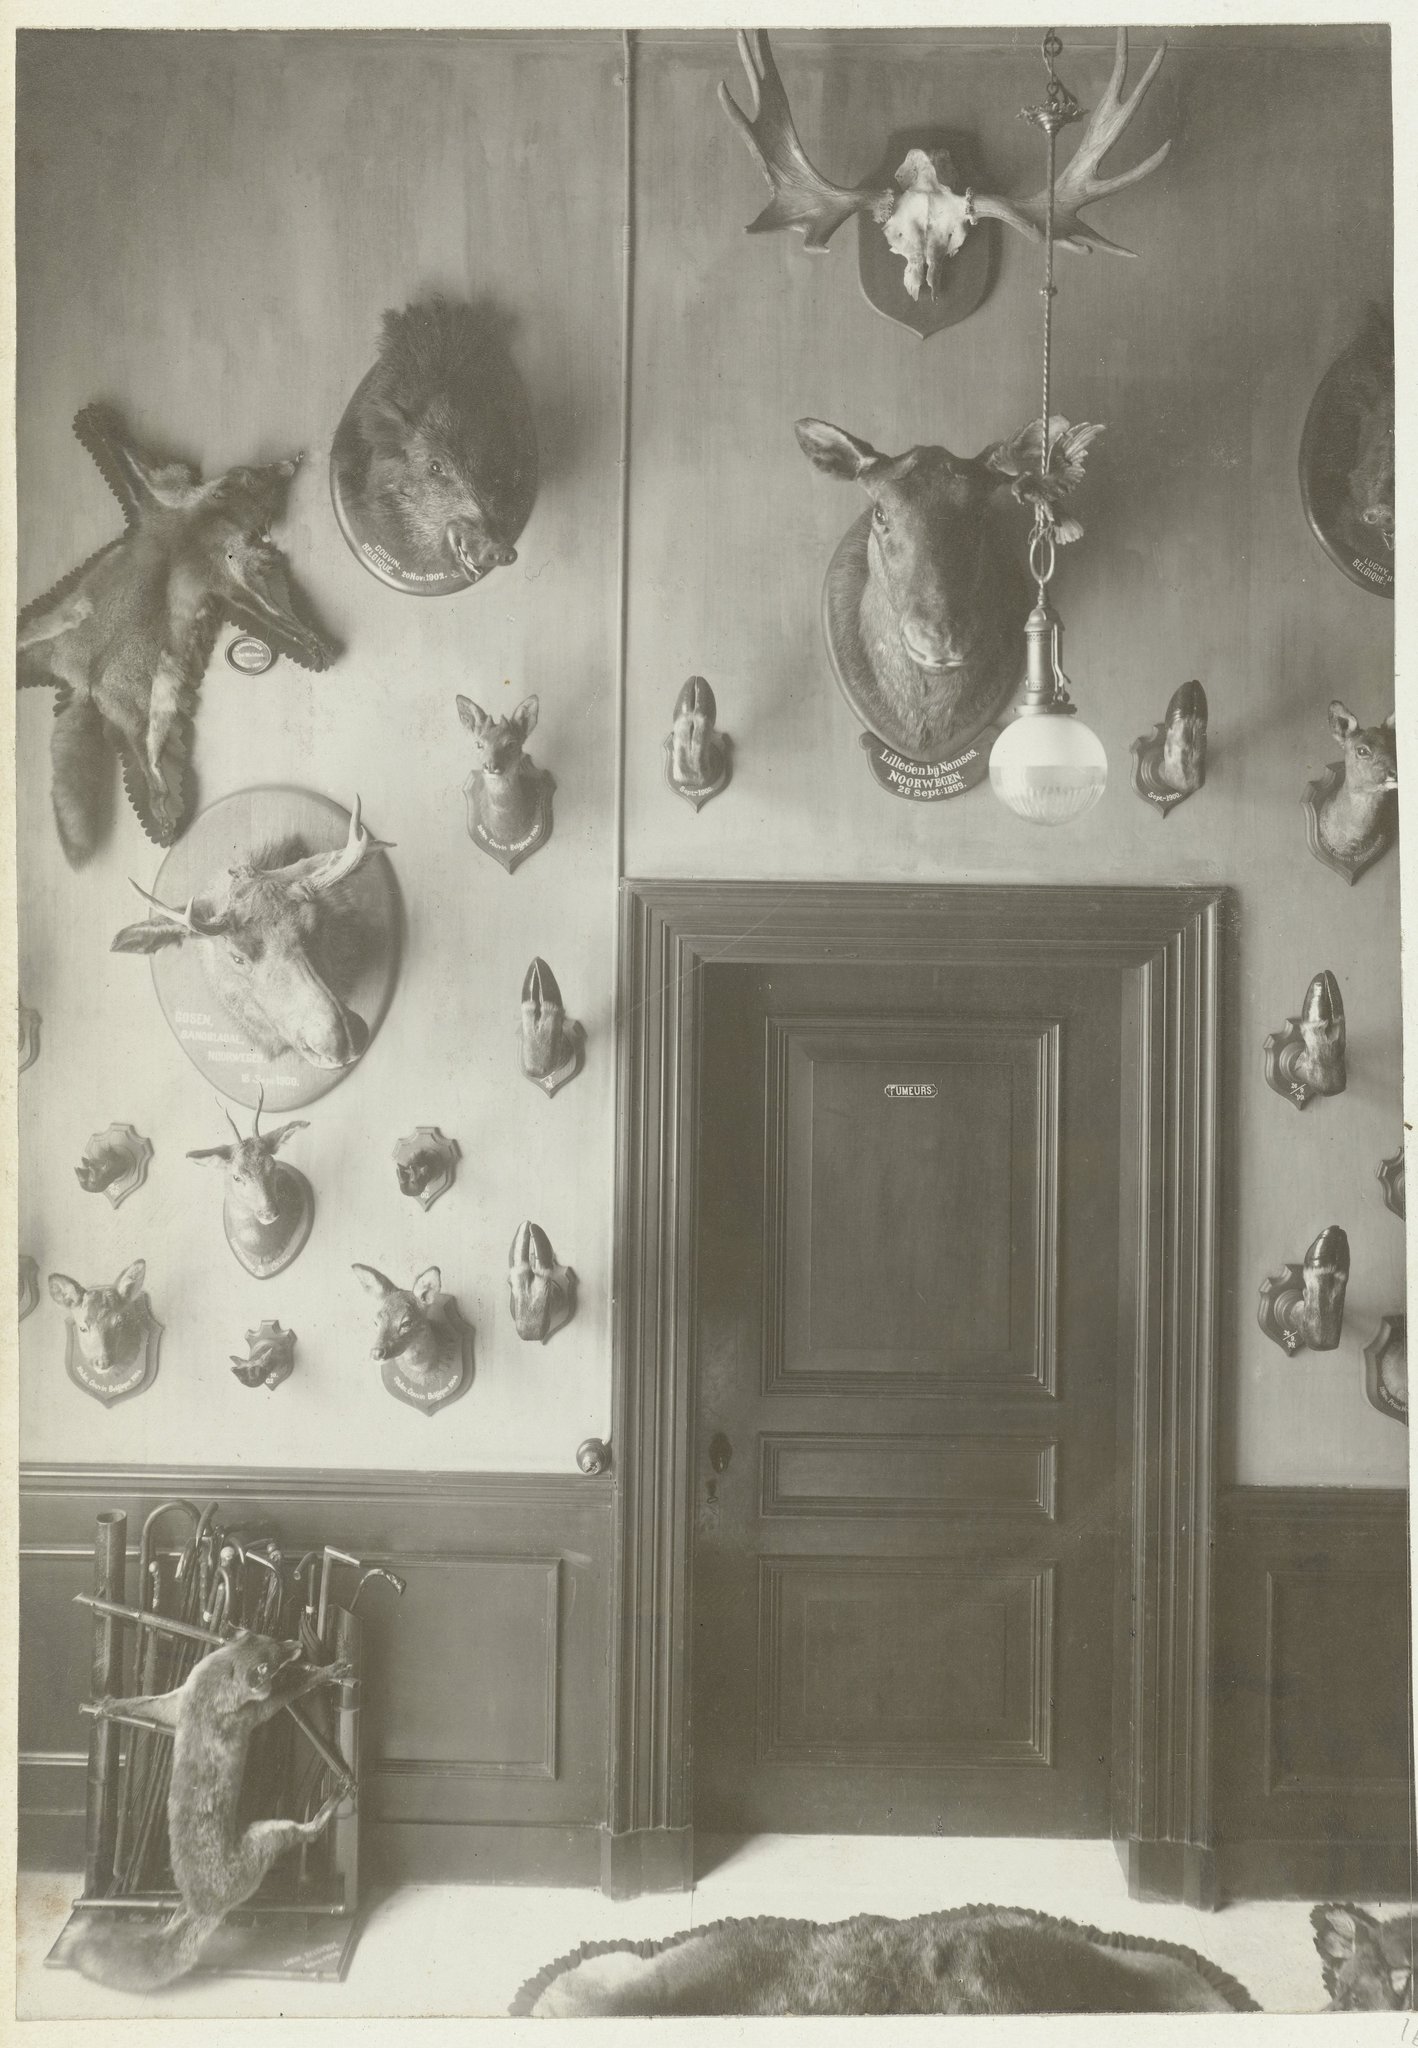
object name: photograph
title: Interieur van landhuis De Wildbaan met jachttrofeeën aan de muur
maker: henry pauw van wieldrecht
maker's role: fotograaf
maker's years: 1863-1912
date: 1903-1907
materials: paper, photographic support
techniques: gelatin silver print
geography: netherlands